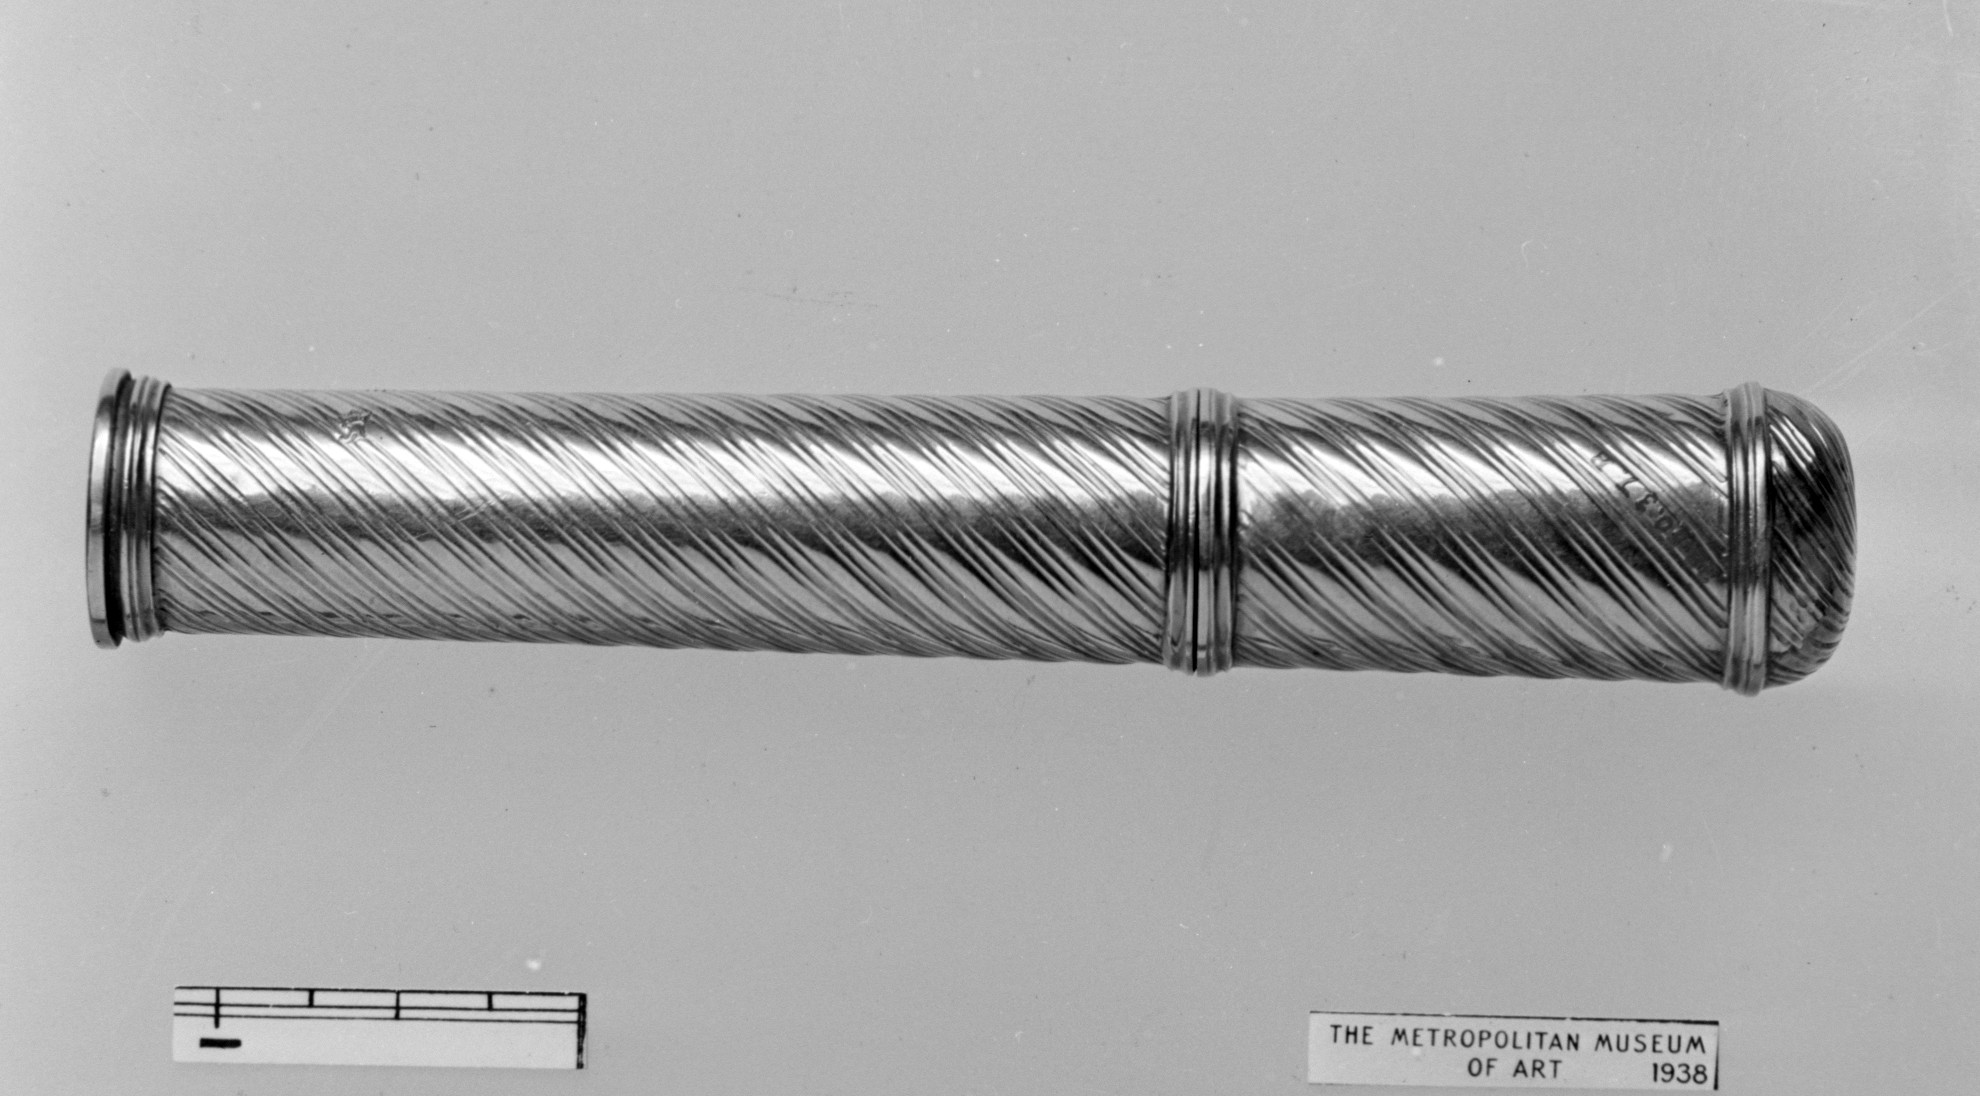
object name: étui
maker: germain chayé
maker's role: artist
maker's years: 1724-1824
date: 1764-1765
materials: gold